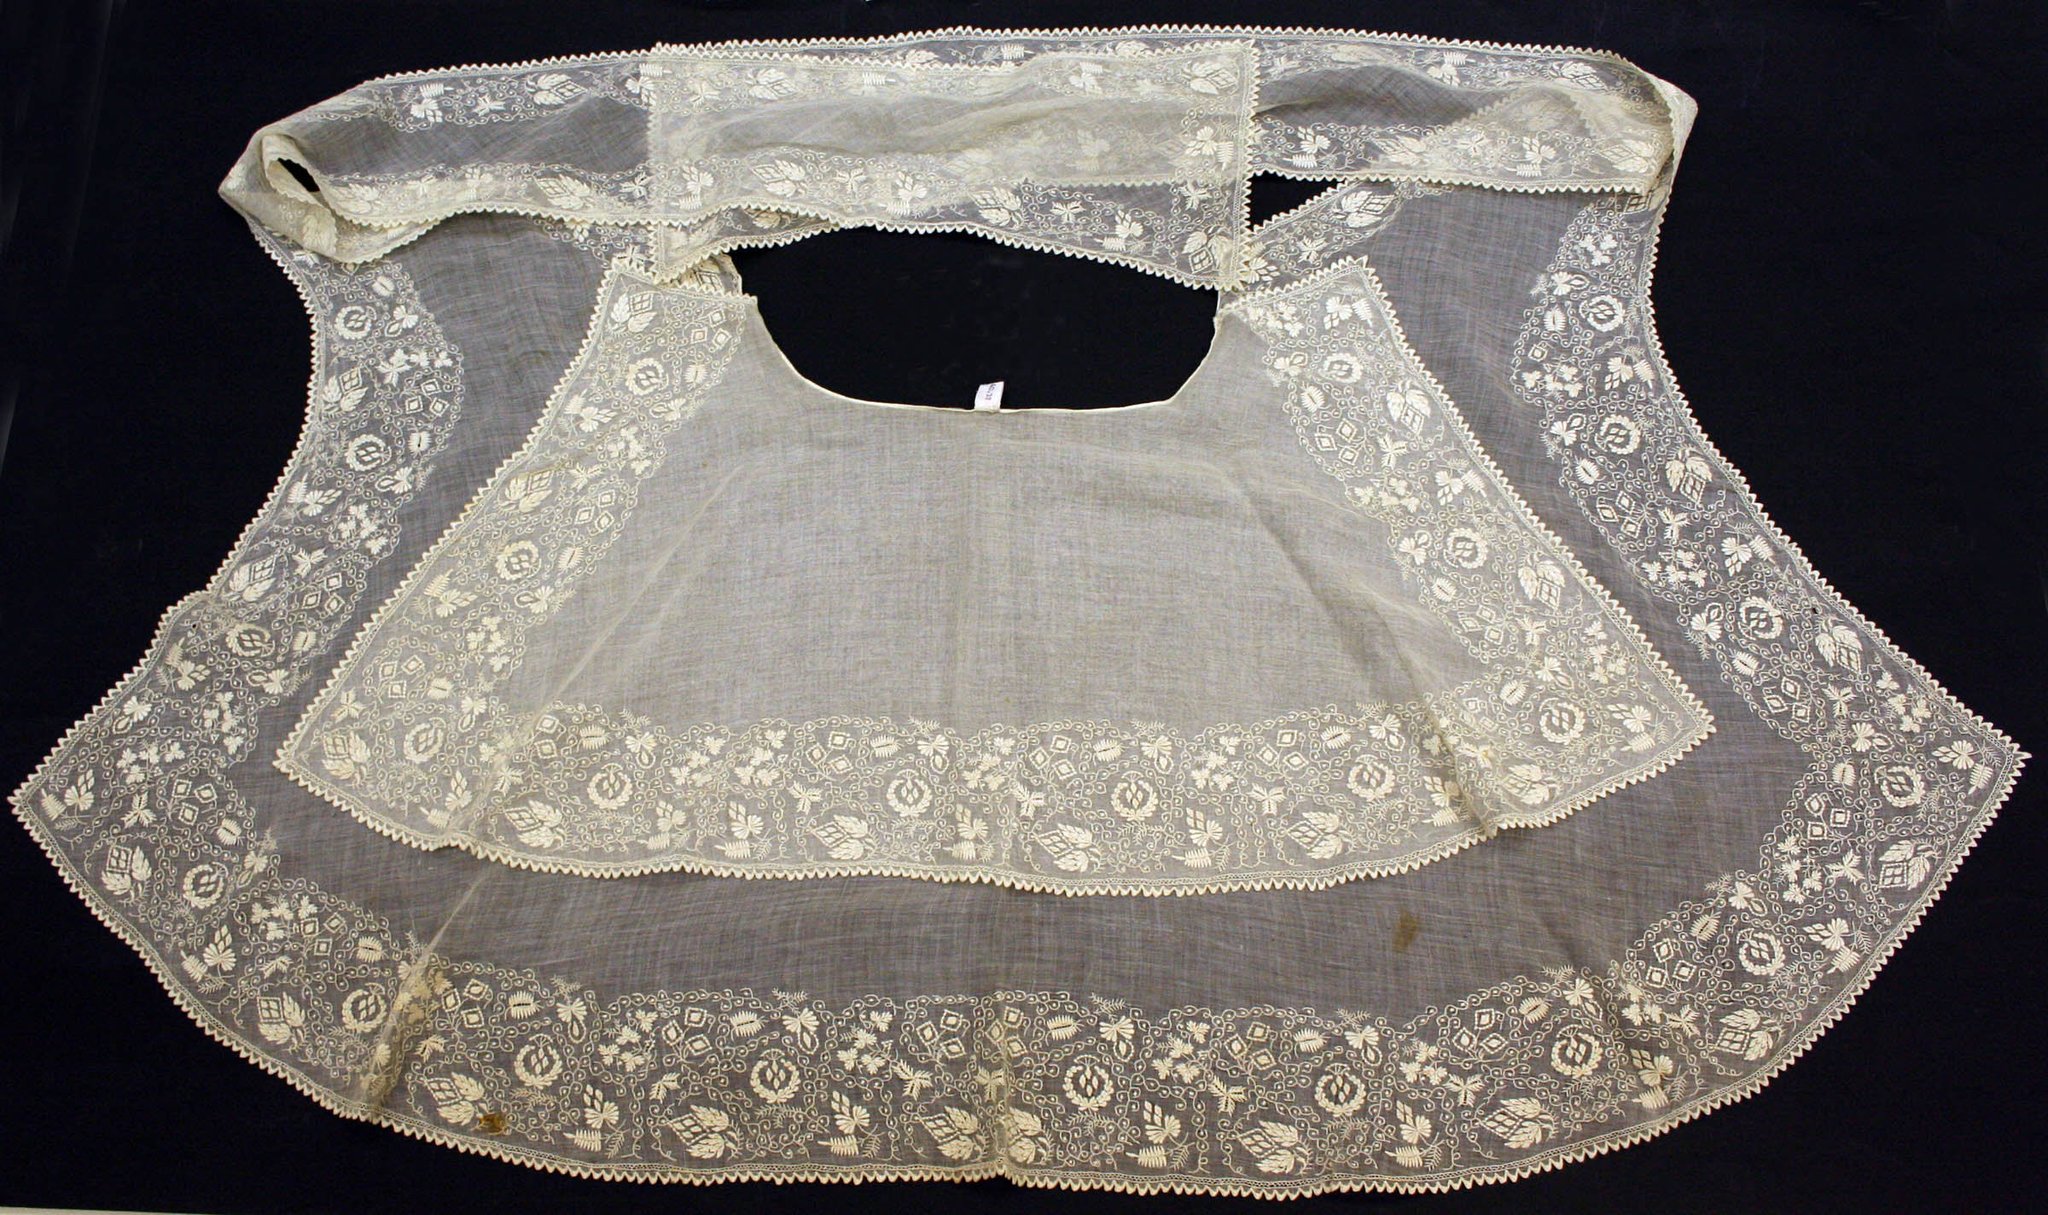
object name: double collar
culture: american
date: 1825-1835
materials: cotton